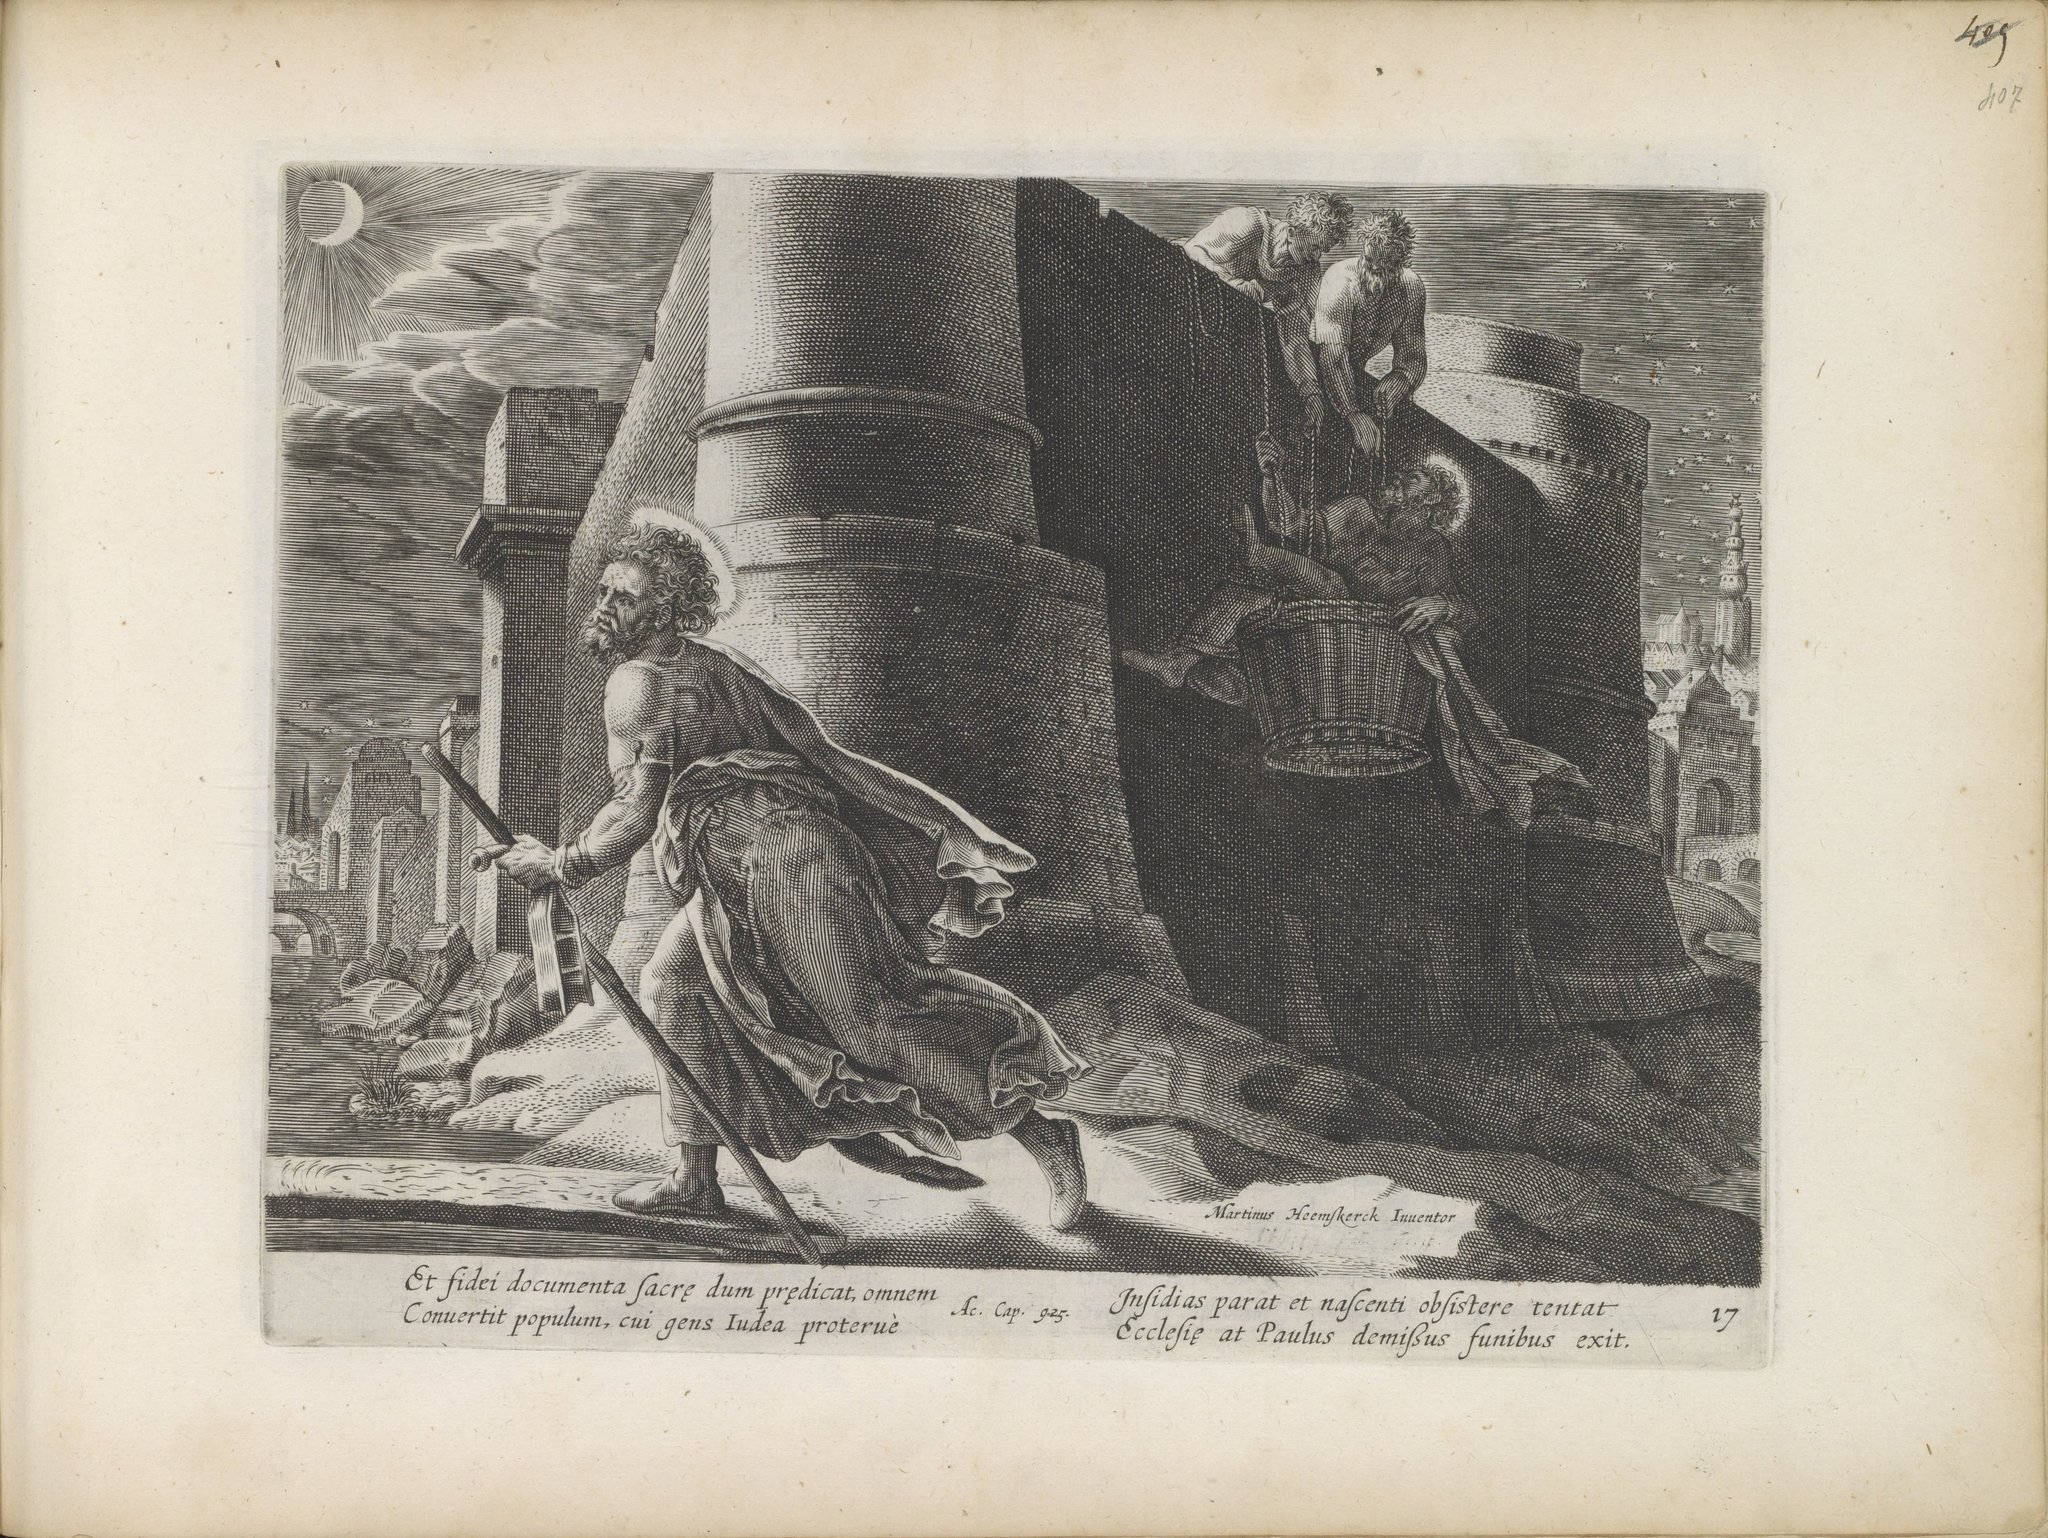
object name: album leaf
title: Paulus' vlucht uit Damascus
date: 1643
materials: paper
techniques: engraving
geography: amsterdam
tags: disciples let paul down the wall of the city in a basket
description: Paulus ontvlucht de stad Damascus in de nacht. Hij wordt van de stadsmuur neergelaten met een mand en trekt dan te voet weg. Onder de voorstelling een verwijzing in het Latijn naar de Bijbeltekst in Hand. 9:25. Deze prent maakt deel uit van een album.